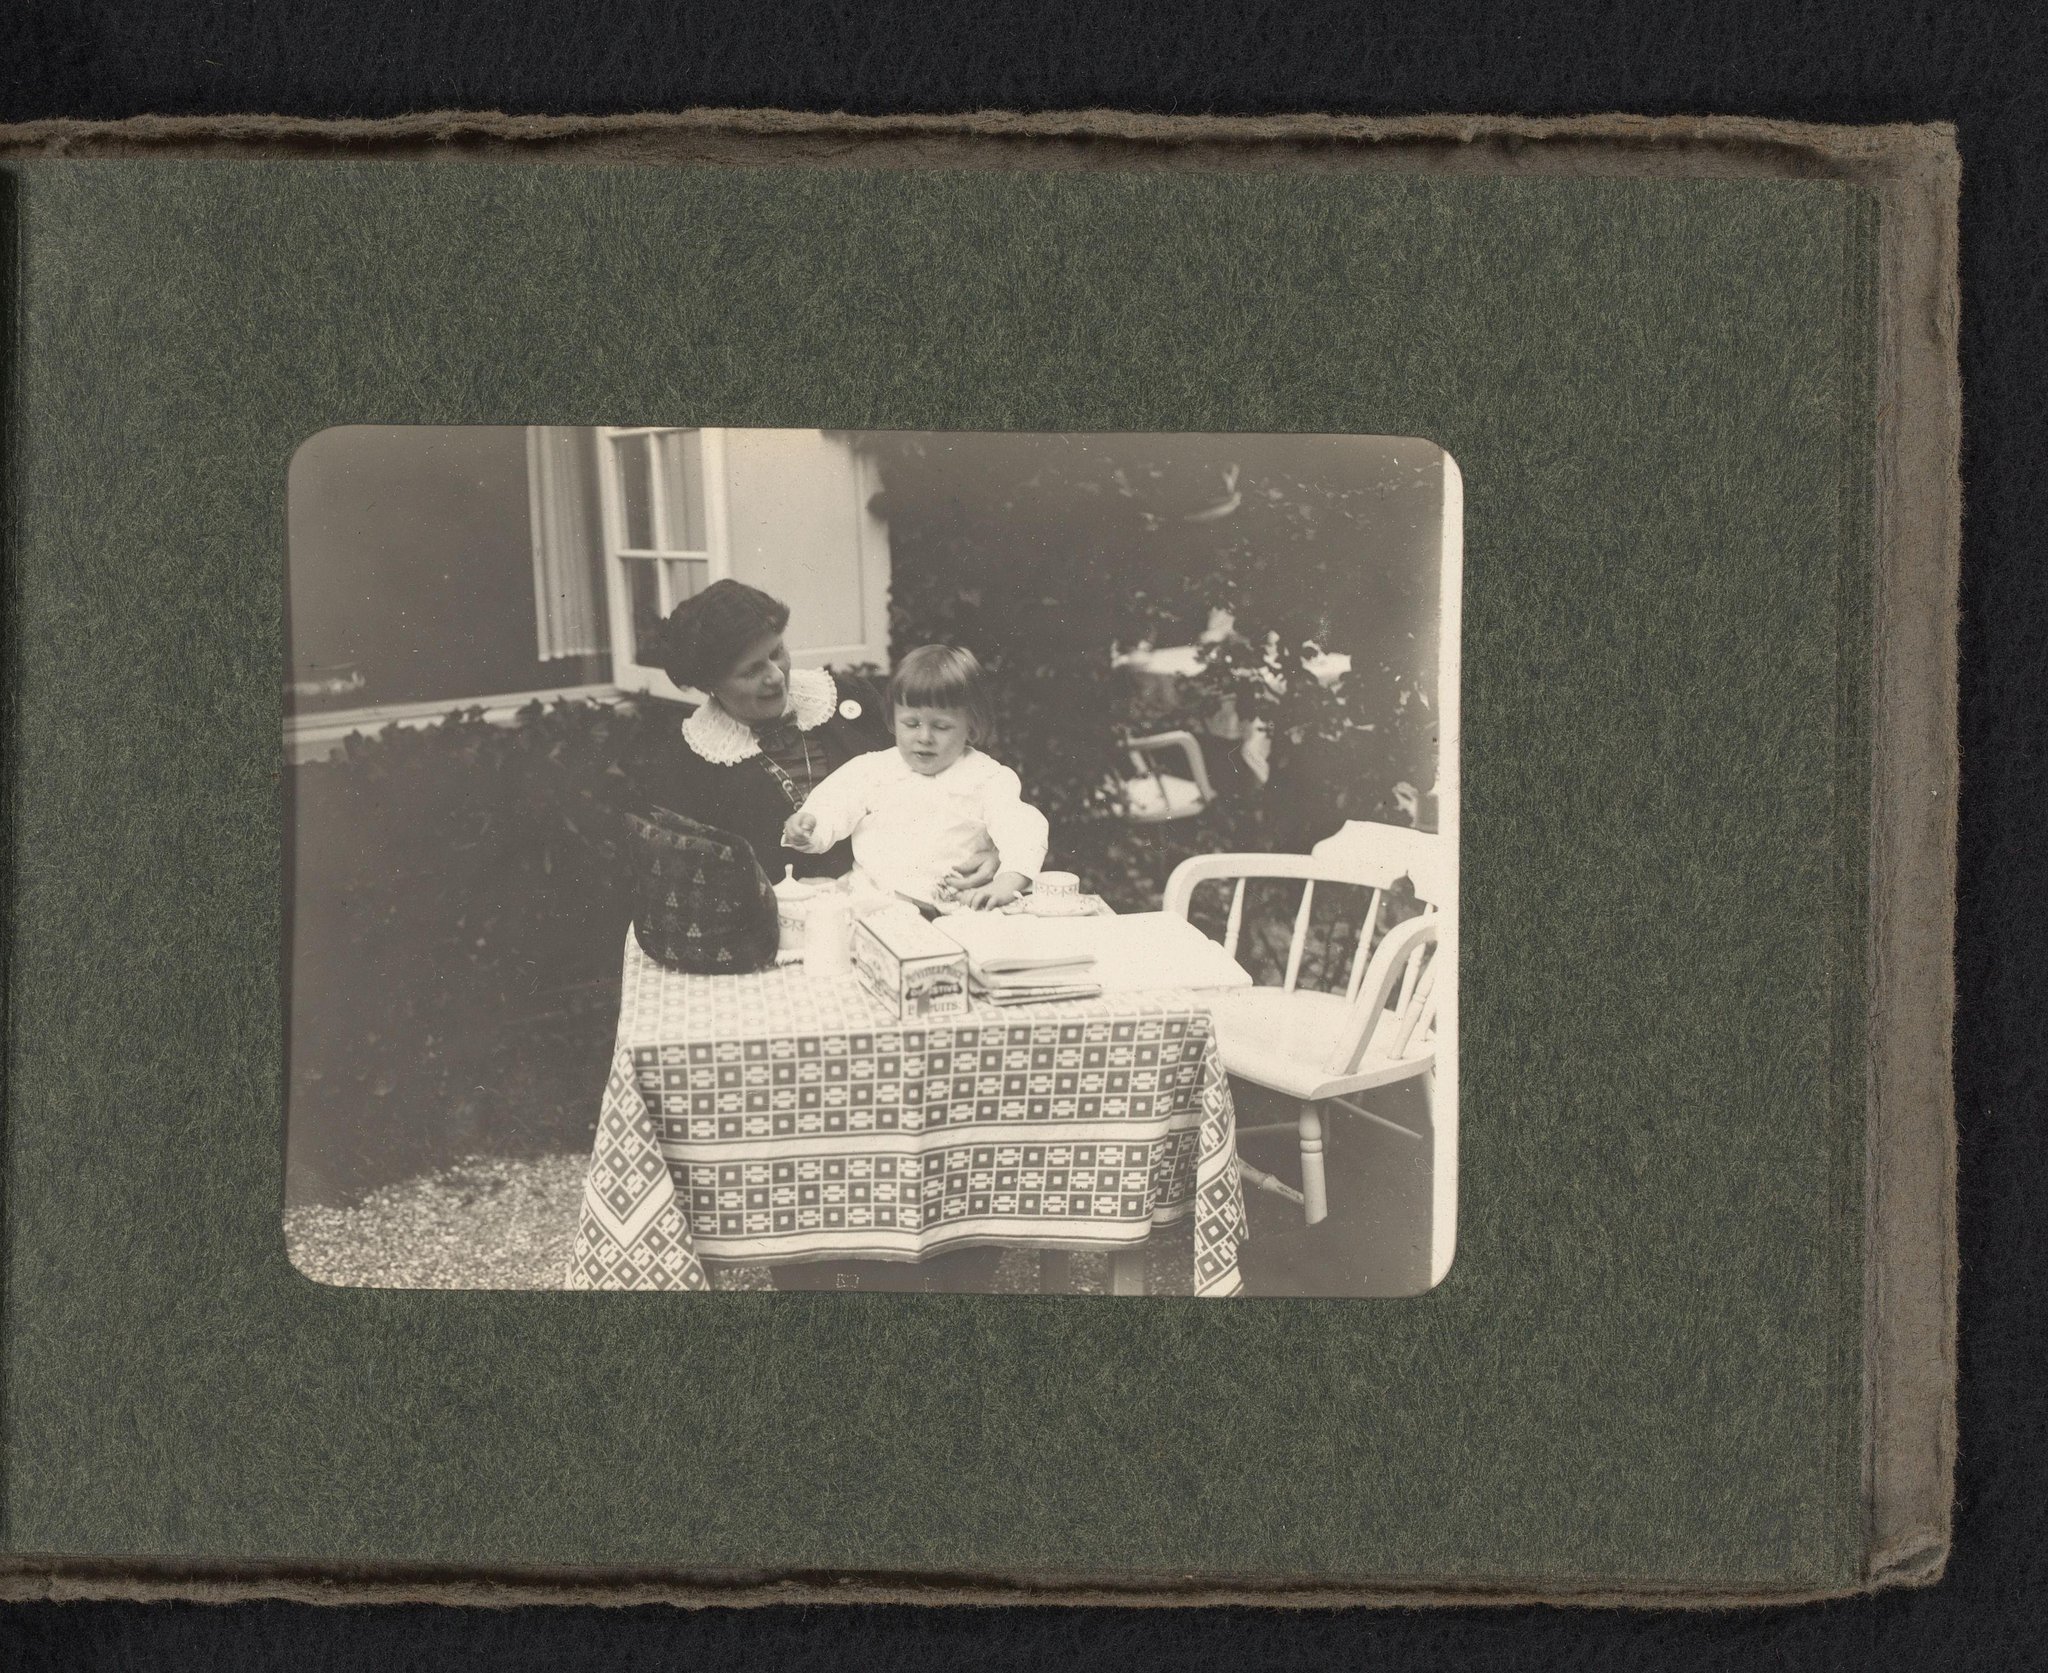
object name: photograph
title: Vrouw, mogelijk Line, met Cay van den Berg op schoot bij hotel Bosch van Bredius te Laren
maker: hendrik herman van den berg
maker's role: amateurfotograaf, jurist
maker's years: 1875-1944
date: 1912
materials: paper, cardboard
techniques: gelatin silver print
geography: laren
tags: carel frederik van den berg (cay), toddler, historical persons - bb - woman, historical persons